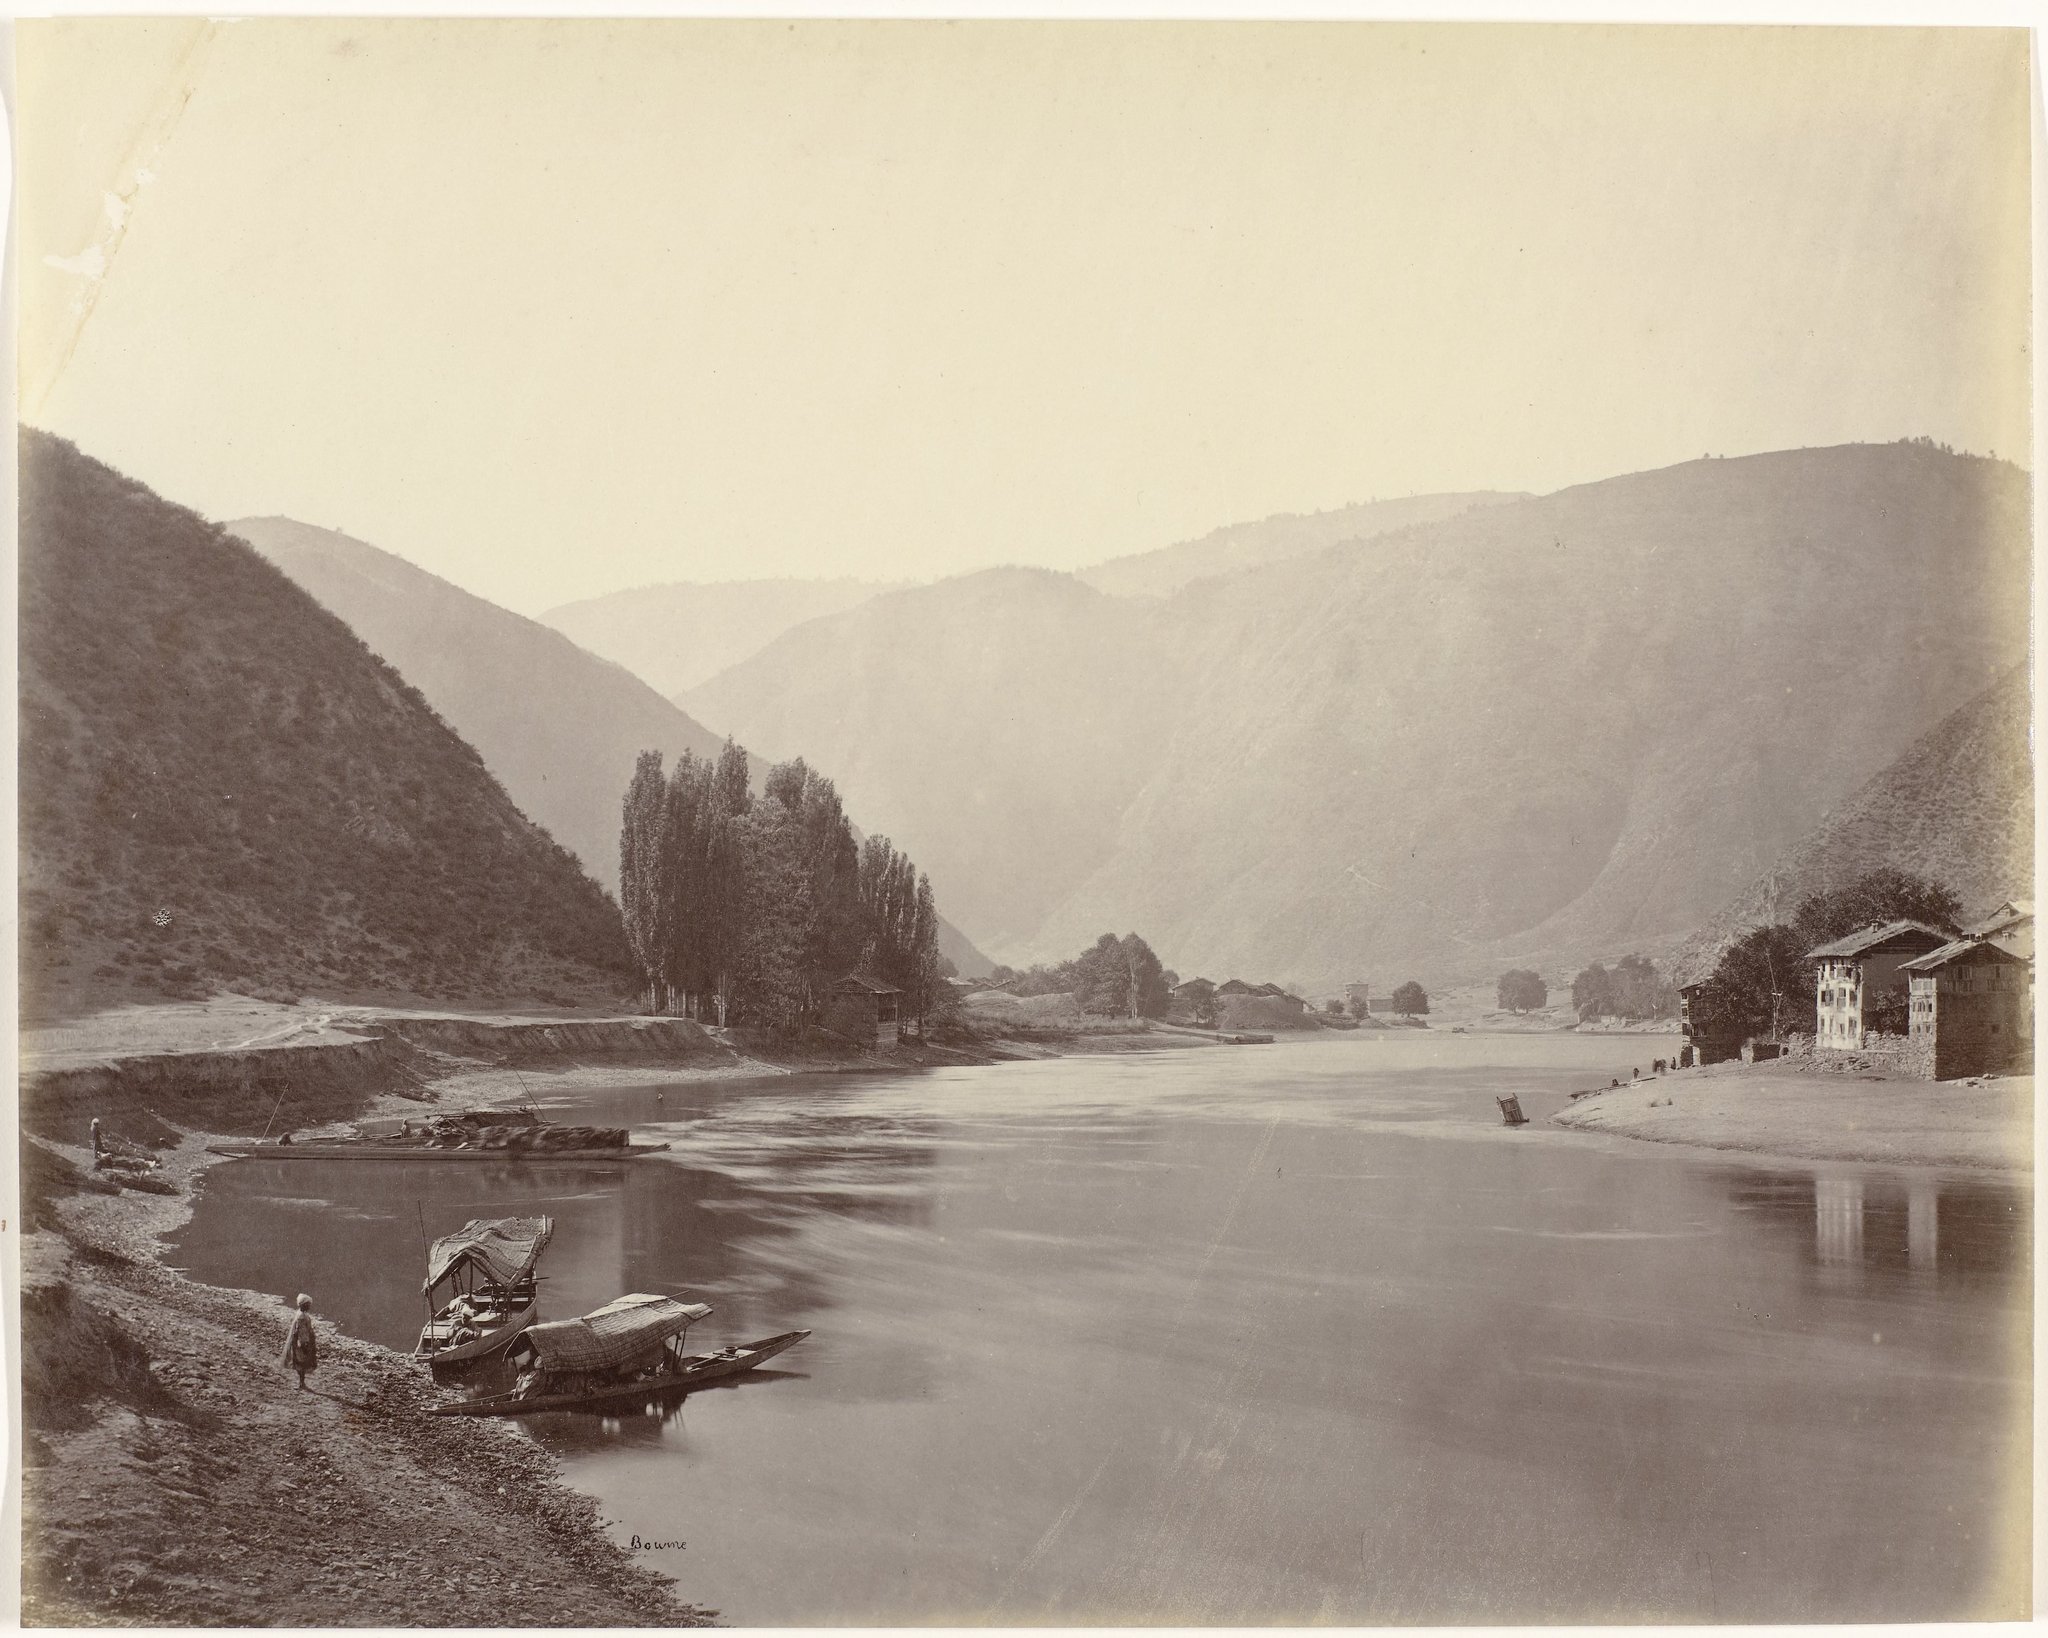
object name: photograph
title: View down the Jhelum river near Baramulla, Jammu & Kashmir, India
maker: samuel bourne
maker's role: fotograaf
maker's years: 1834-1912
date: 1864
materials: paper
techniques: albumen print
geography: jammu and kashmir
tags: river, mountains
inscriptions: number: ‘997’, name: ‘Bourne’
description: Aan de stijl van de boten links op de foto, genaamd shikara, is af te leiden dat deze foto in Jammu en Kasjmir is gemaakt.